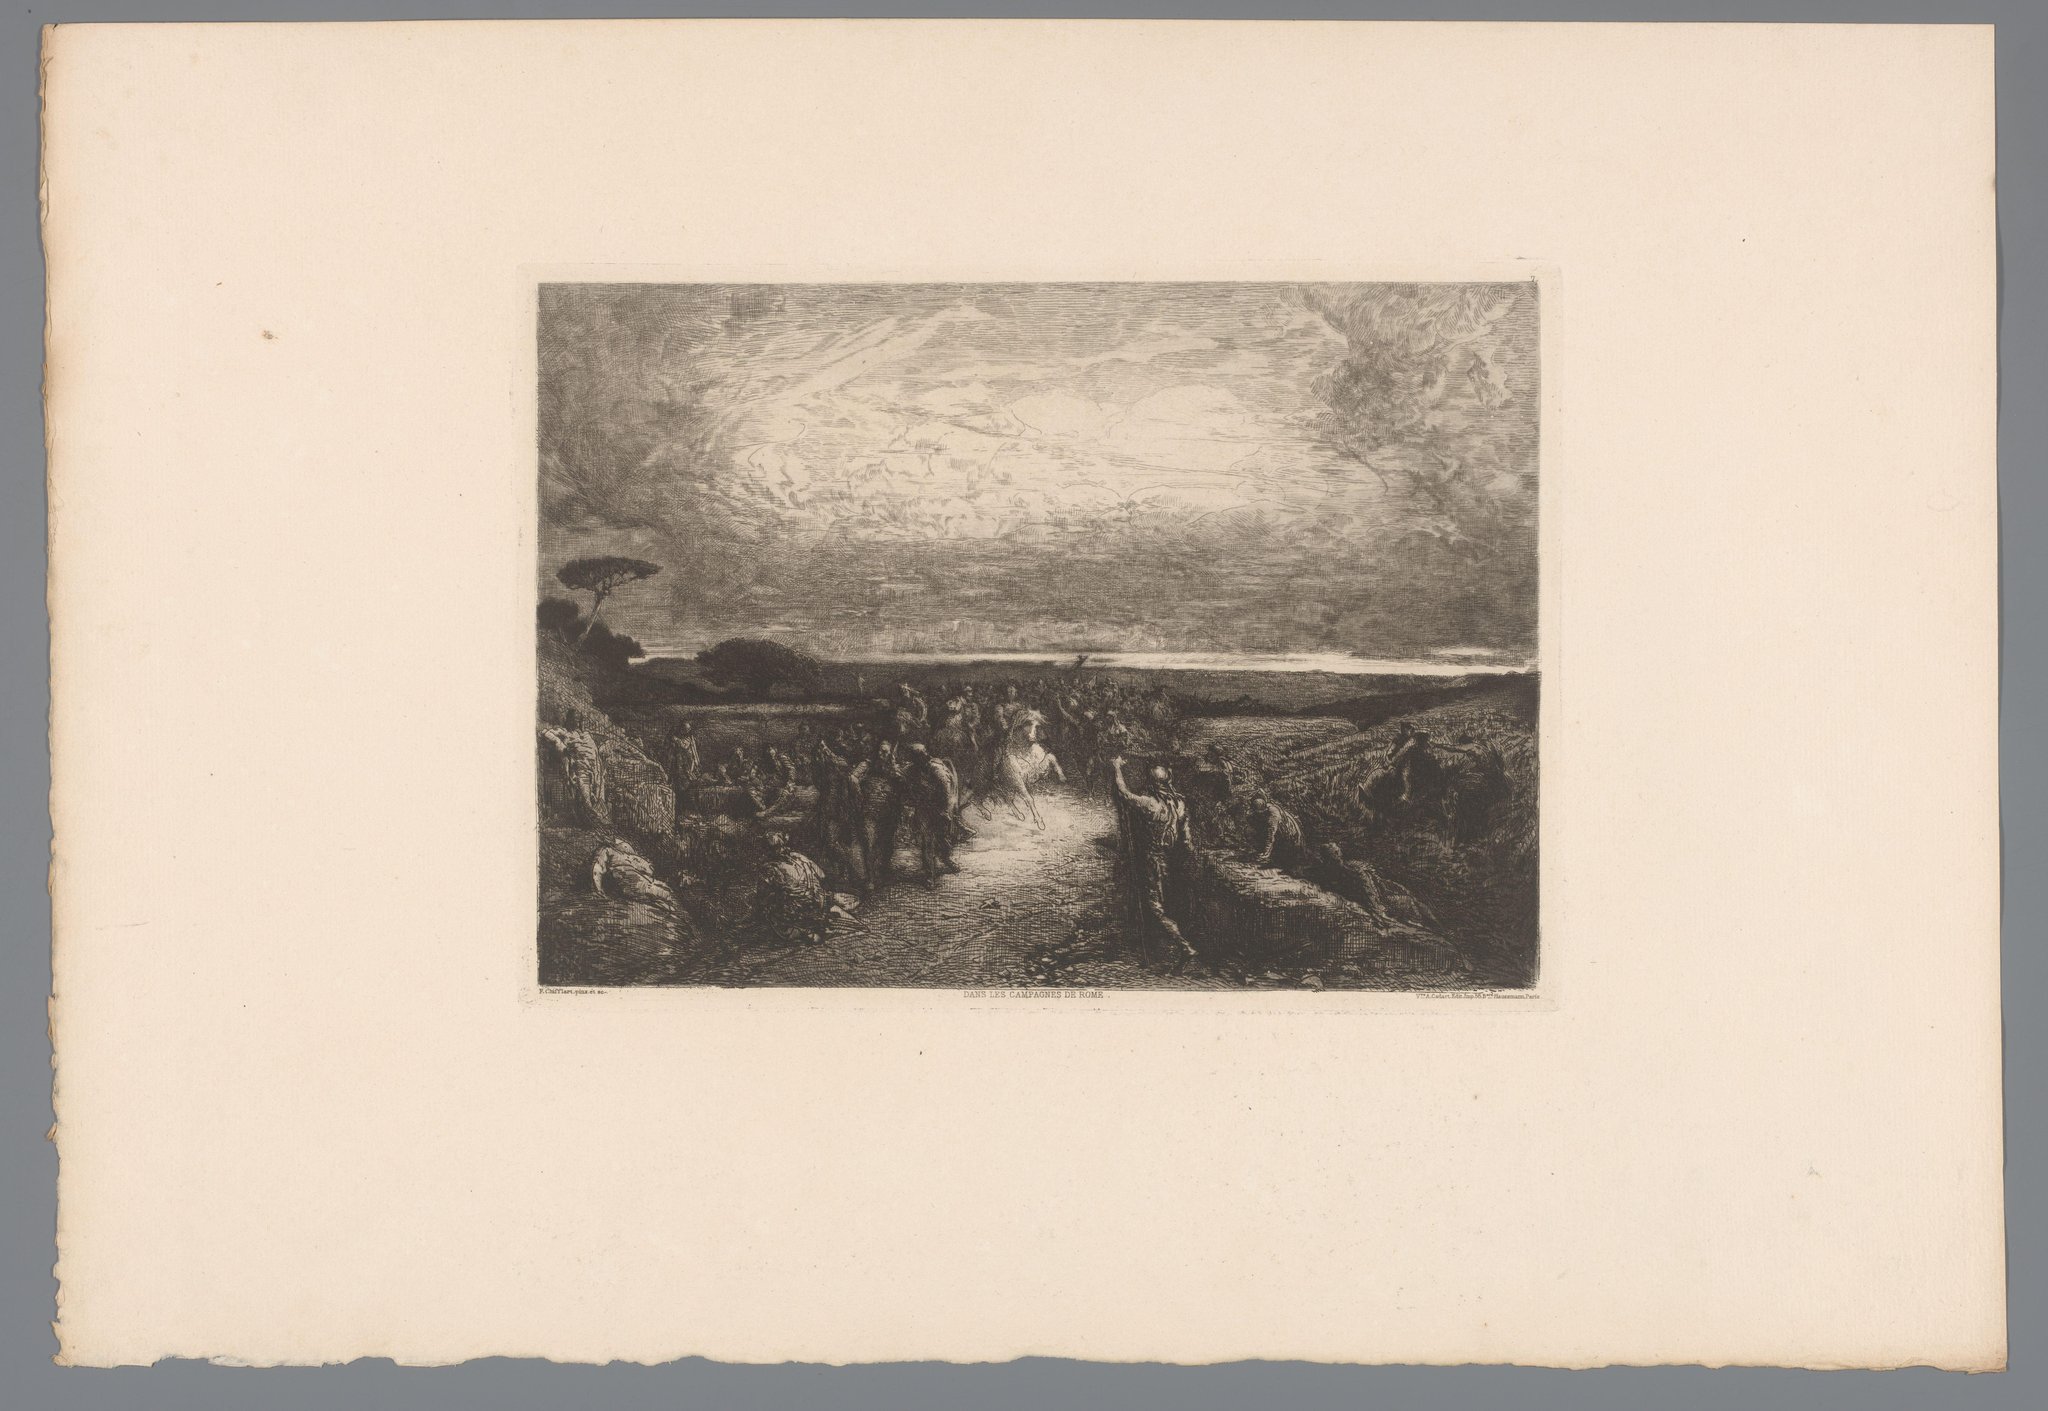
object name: print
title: Dans les campagnes de Rome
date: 1881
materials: paper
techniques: drypoint, etching, intaglio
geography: paris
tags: riding a horse, ass, or mule; rider, horseman, military parade, pageant, plain, rome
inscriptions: collector's mark: ‘AFE v S’, collector's mark: Lugt 2760, collector's mark: Lugt 2228